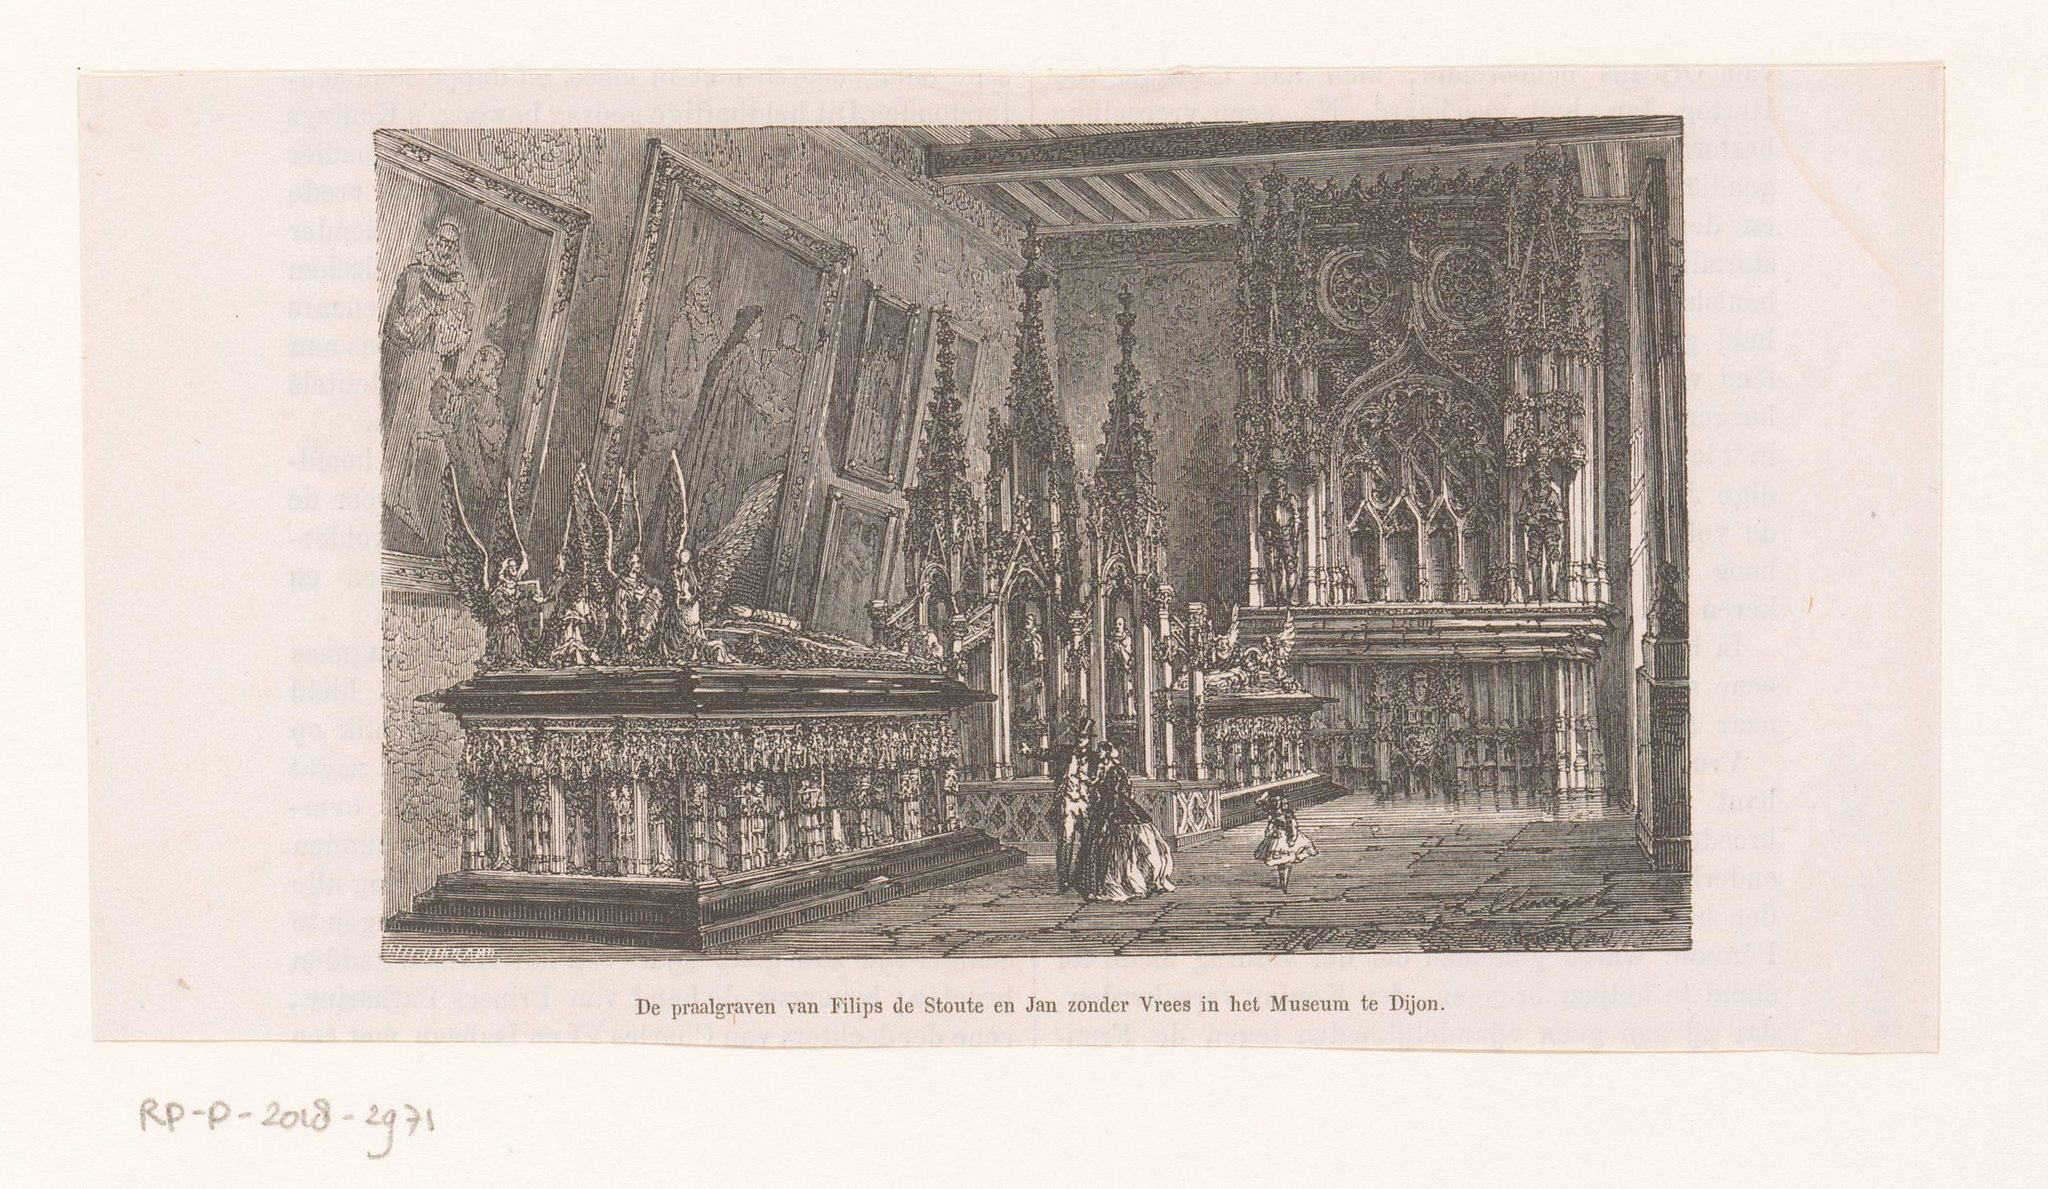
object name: print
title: De praalgraven van Filips de Stoute en Jan zonder Vrees in het Museum te Dijon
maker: Anonymous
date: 1850-1890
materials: paper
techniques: letterpress printing, engraving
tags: halle, grave, tomb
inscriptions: collector's mark: Lugt 2228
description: Zaal van het Museum te Dijon met de praalgraven van Filips de Stoute en Jan zonder Vrees.